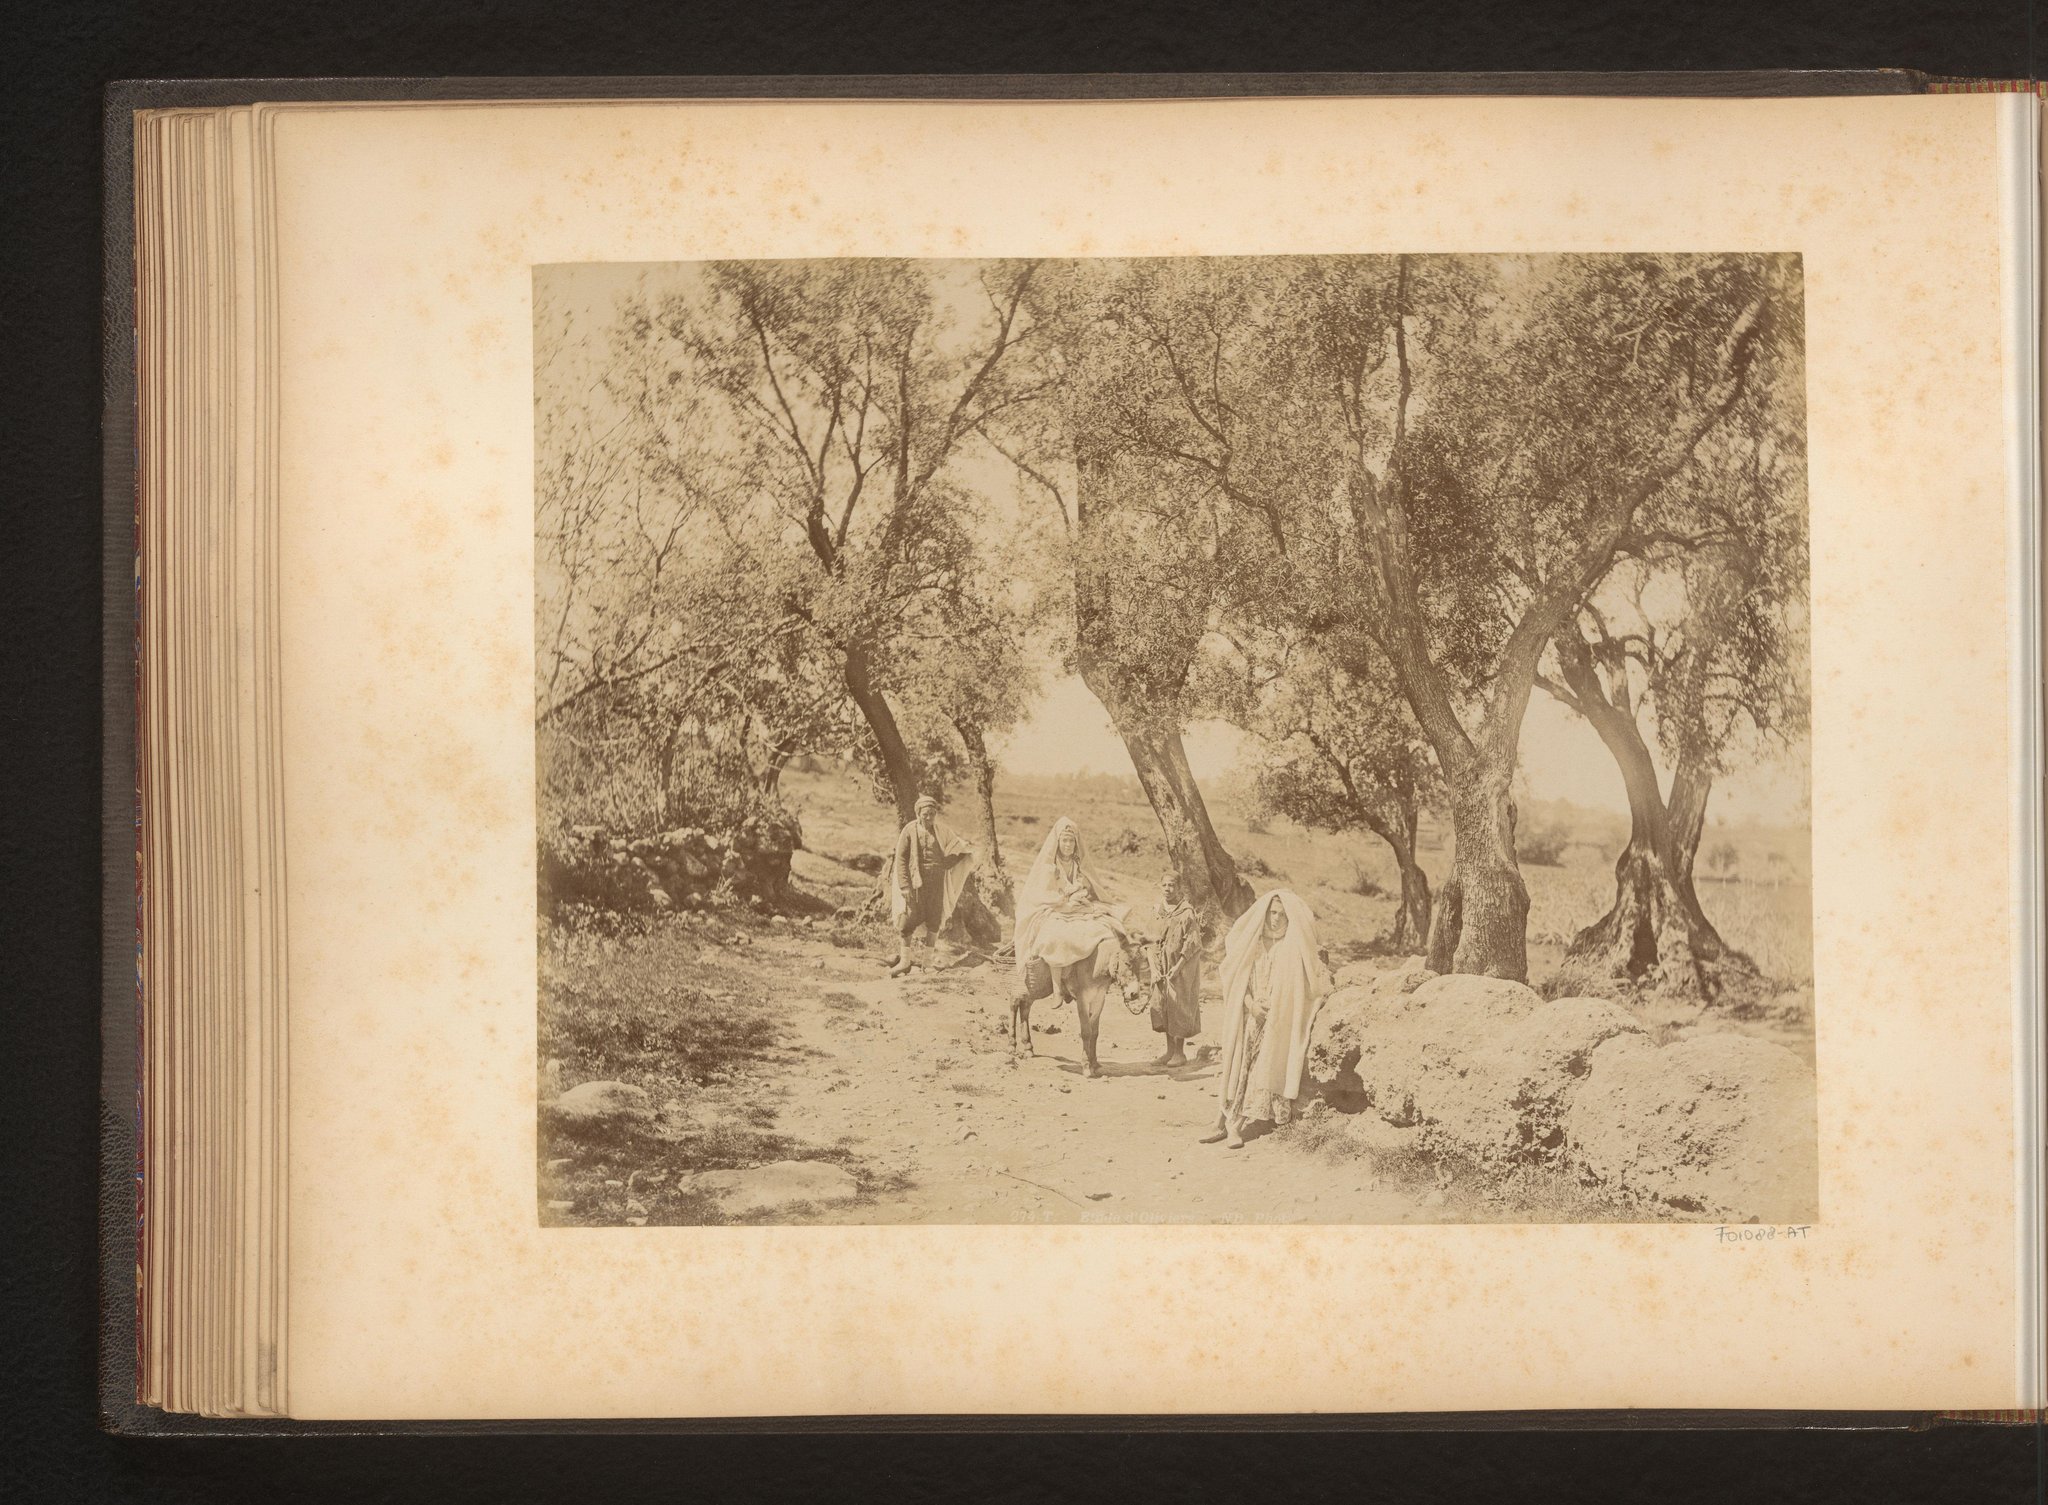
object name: photograph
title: Mannen en vrouw met ezel op een pad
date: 1880-1900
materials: photographic support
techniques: albumen print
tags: riding a horse, ass, or mule; rider, horseman, historical persons, forest path or lane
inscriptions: check stamp: ‘J. Kuhn Editeur/ 220 Rue de Rivoli Paris’, number: ‘274 T.’